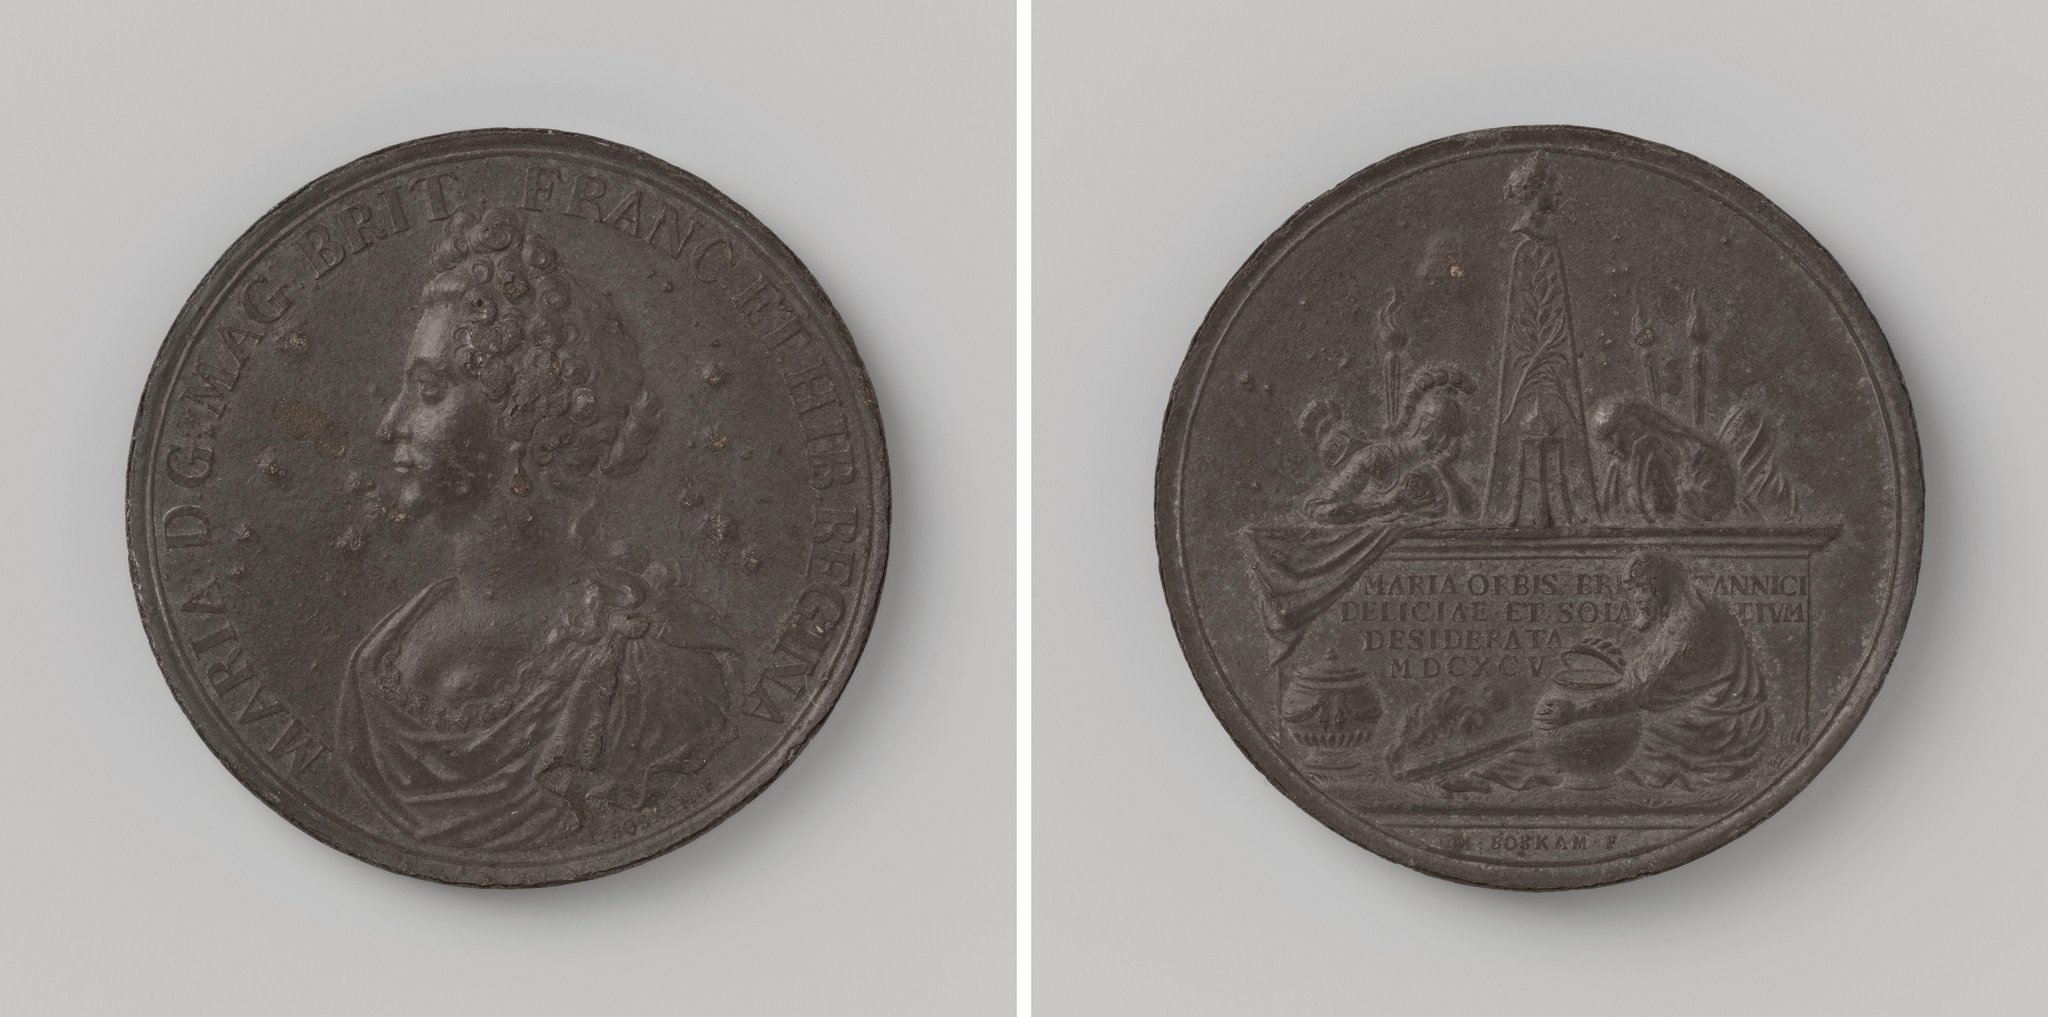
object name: copy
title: Overlijden van Maria II van Engeland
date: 1695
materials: lead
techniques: striking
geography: amsterdam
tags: london, maria ii stuart (koningin van engeland, schotland en ierland)